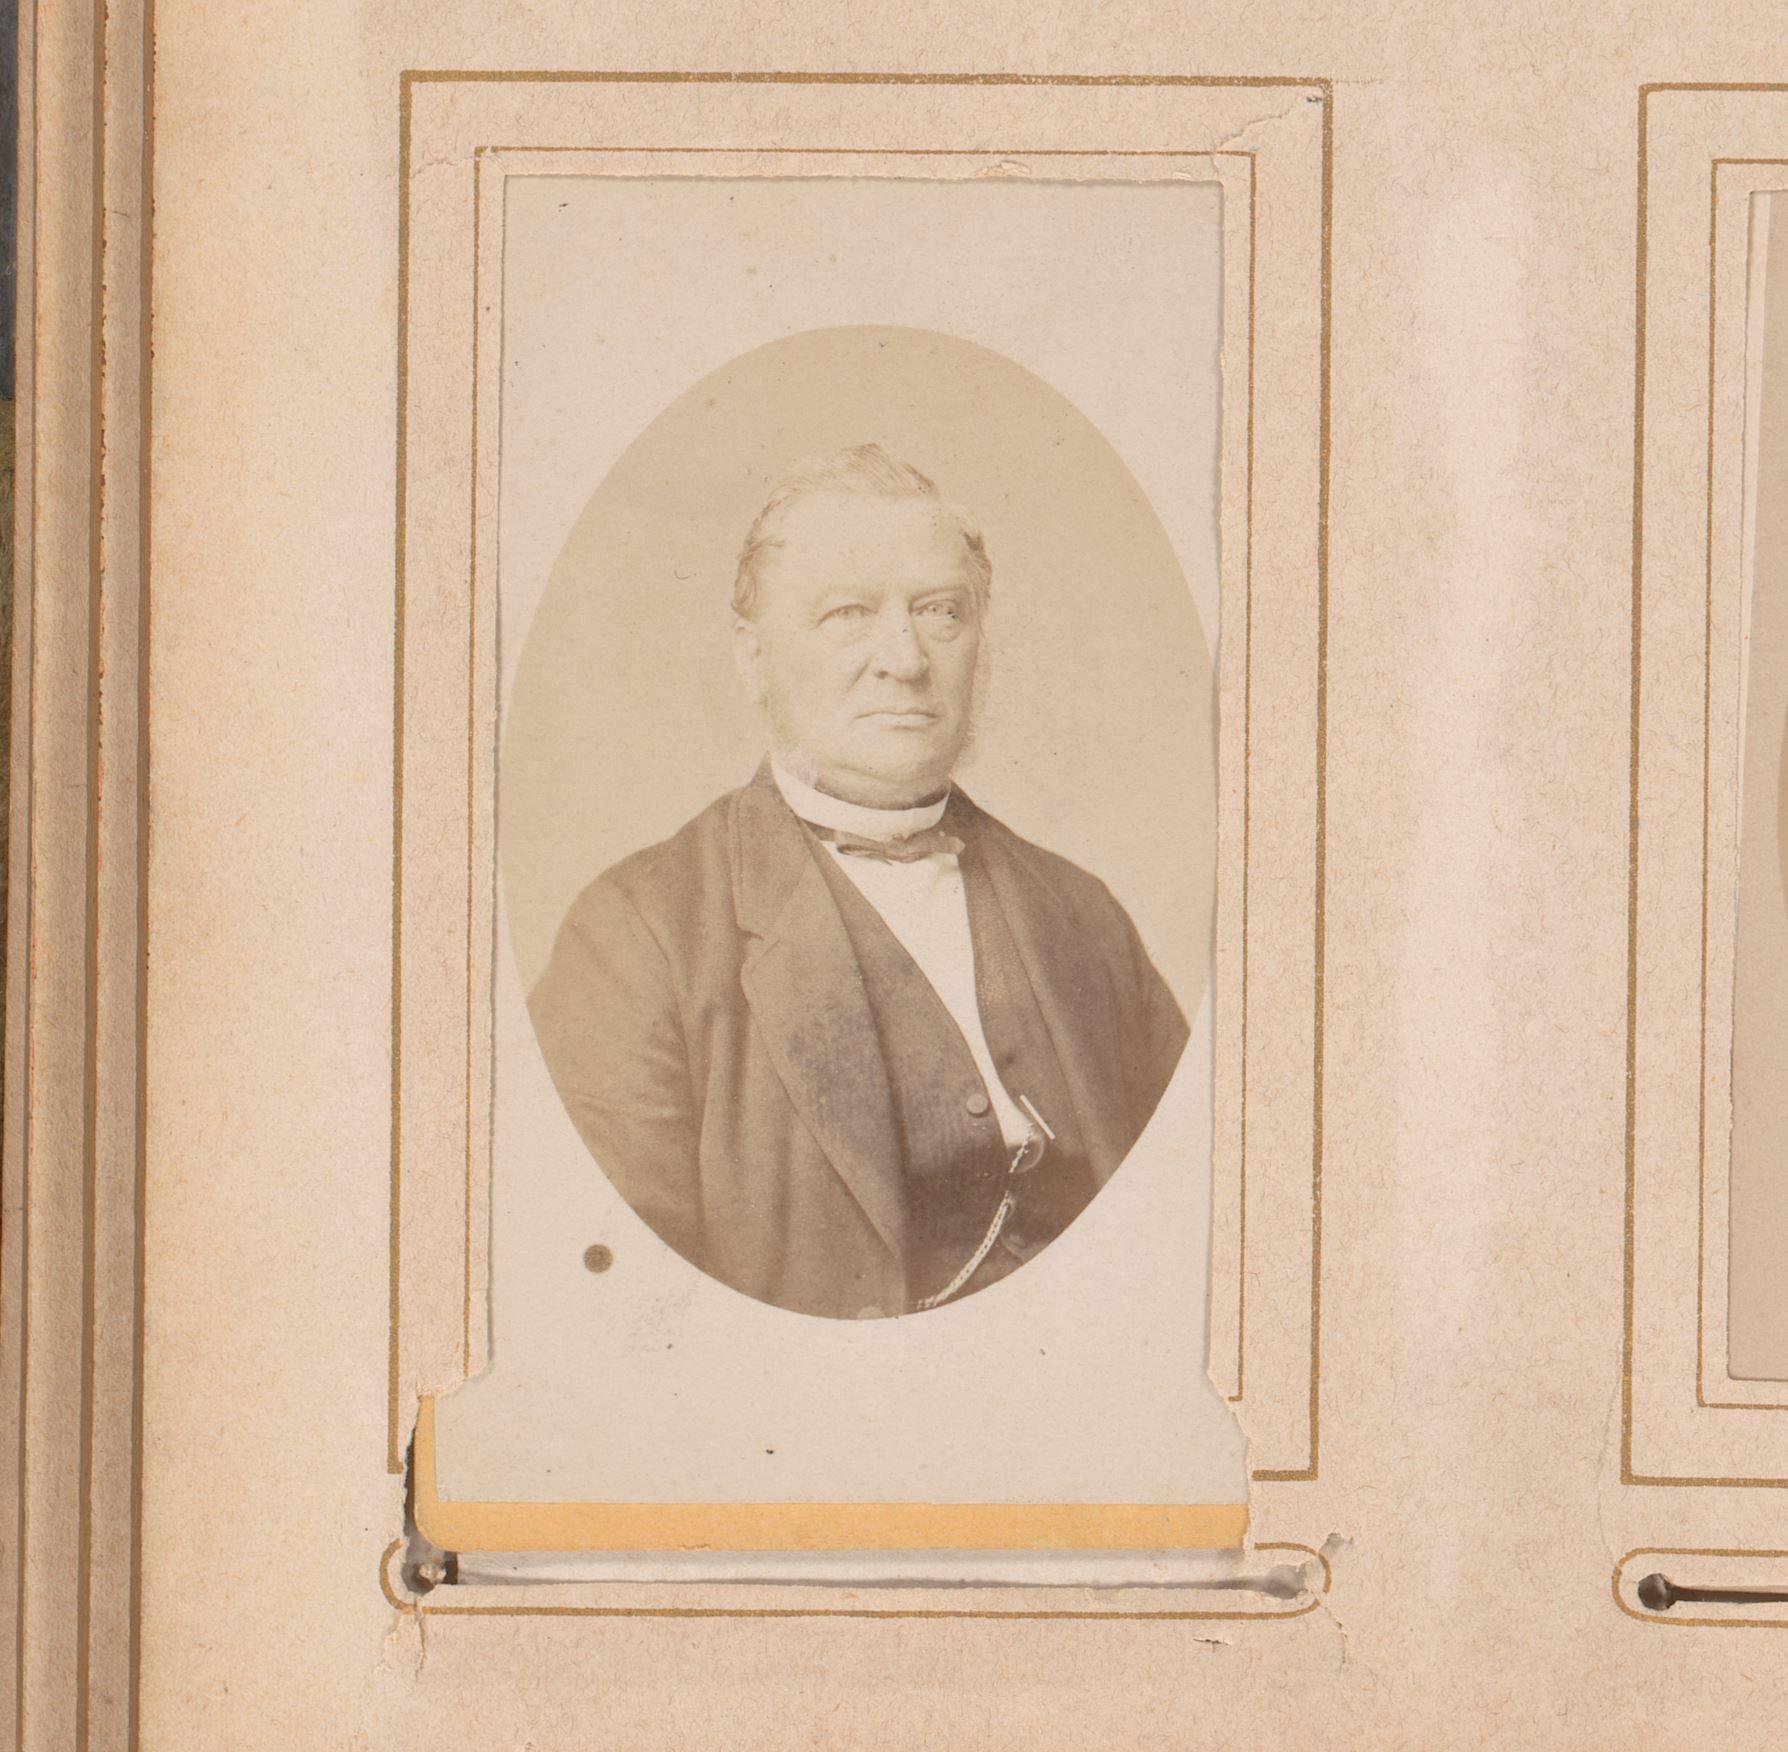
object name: carte de visite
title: Portret van een oude man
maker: dirk le grand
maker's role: artist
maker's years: 1819-1891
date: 1872-1876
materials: cardboard, photographic support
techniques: albumen print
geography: breda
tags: historical persons, old man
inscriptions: inscription: ‘Photographie/ D. le Grand/ Hoek, Bosch en Brouwerijstraat D 234/ Breda’